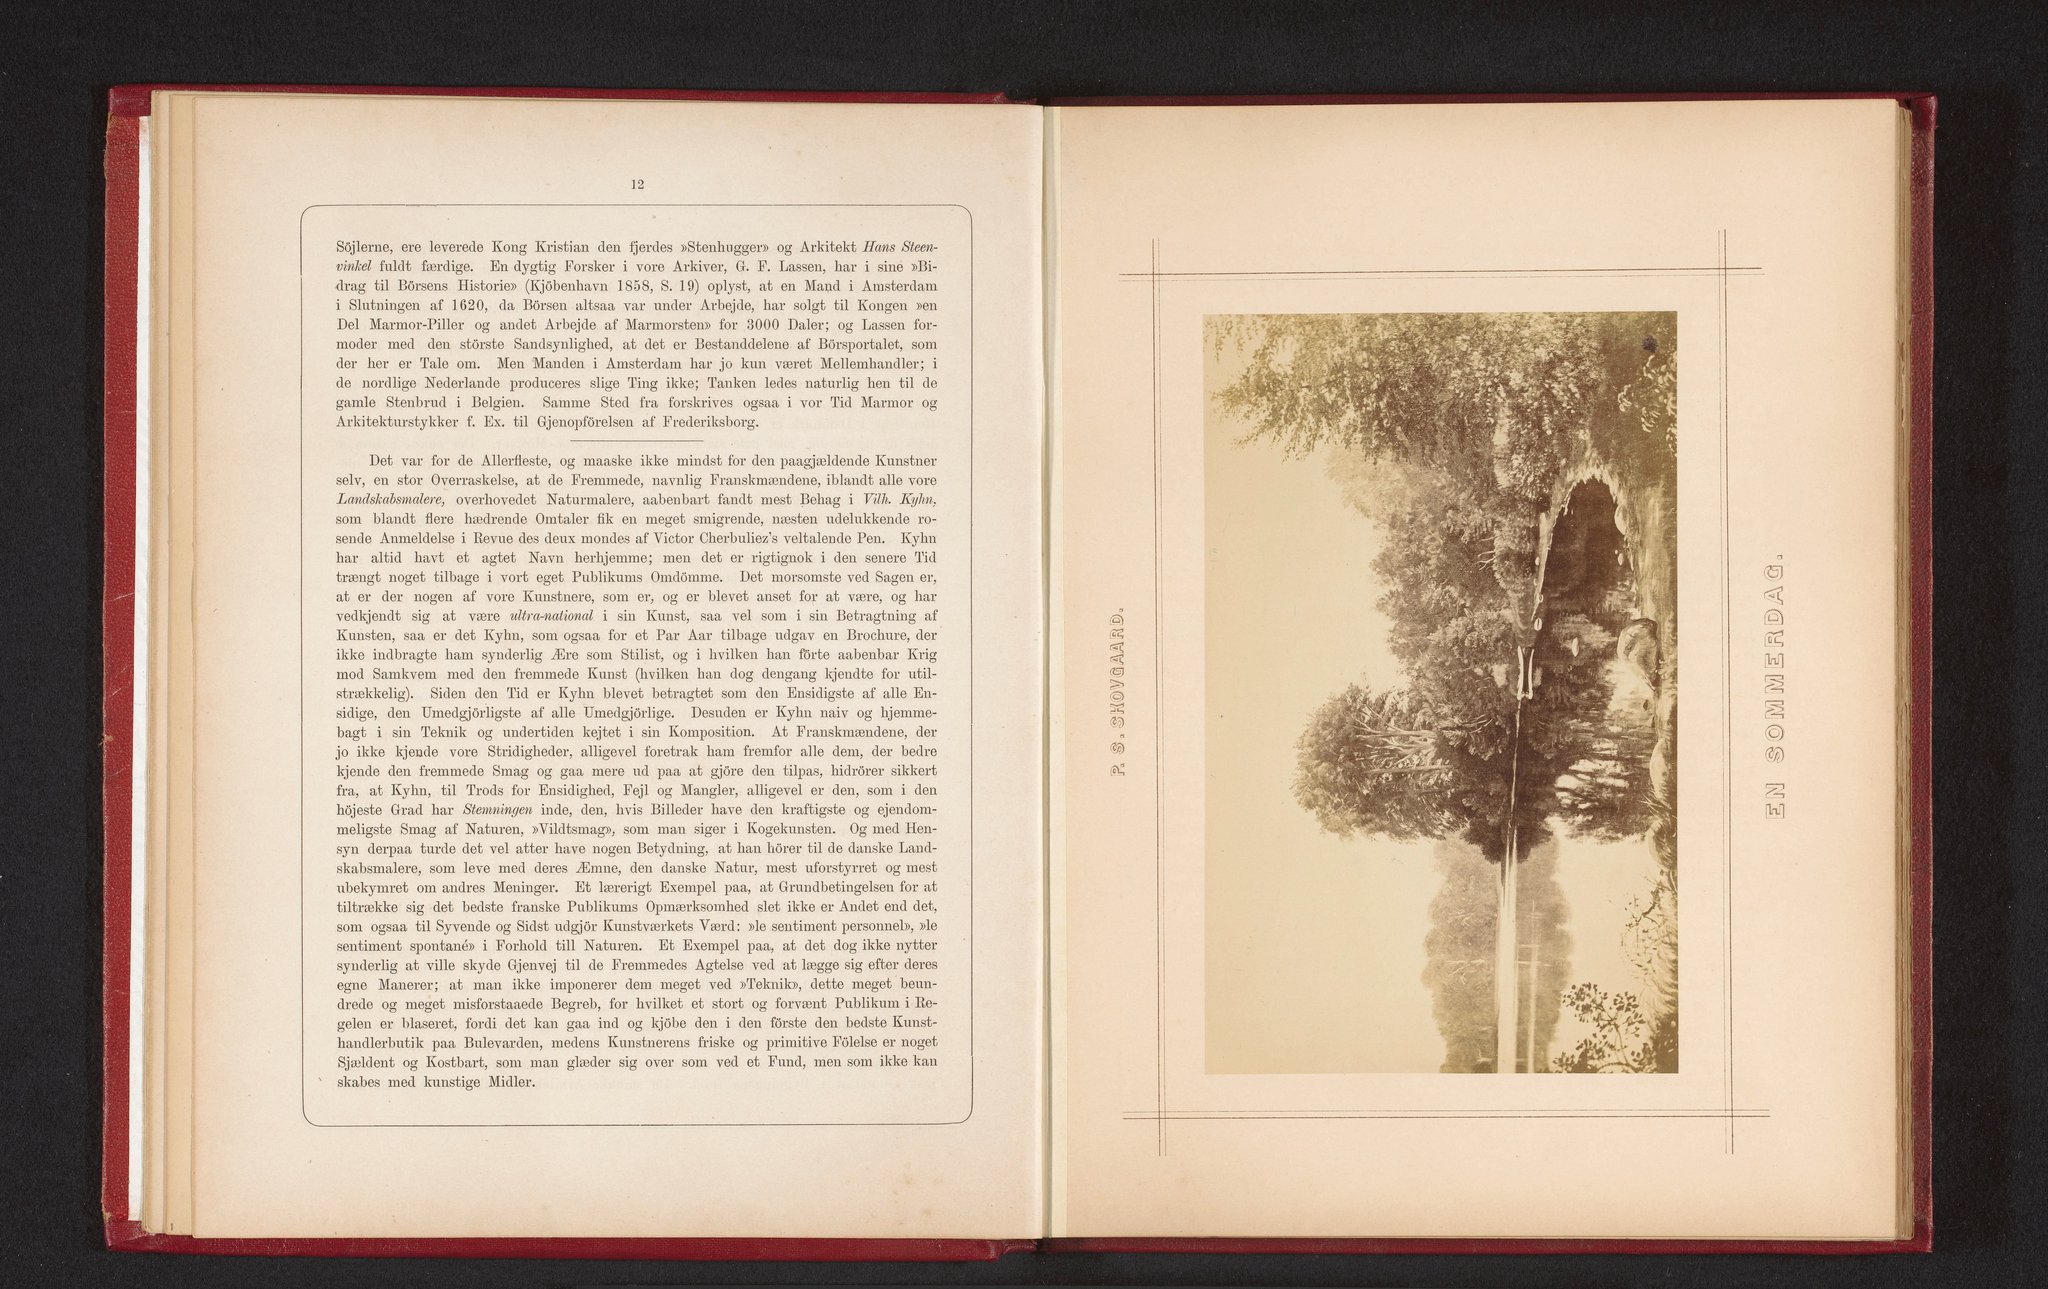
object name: reproduction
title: En Sommerdag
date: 1874-1879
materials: photographic support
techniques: albumen print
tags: lake